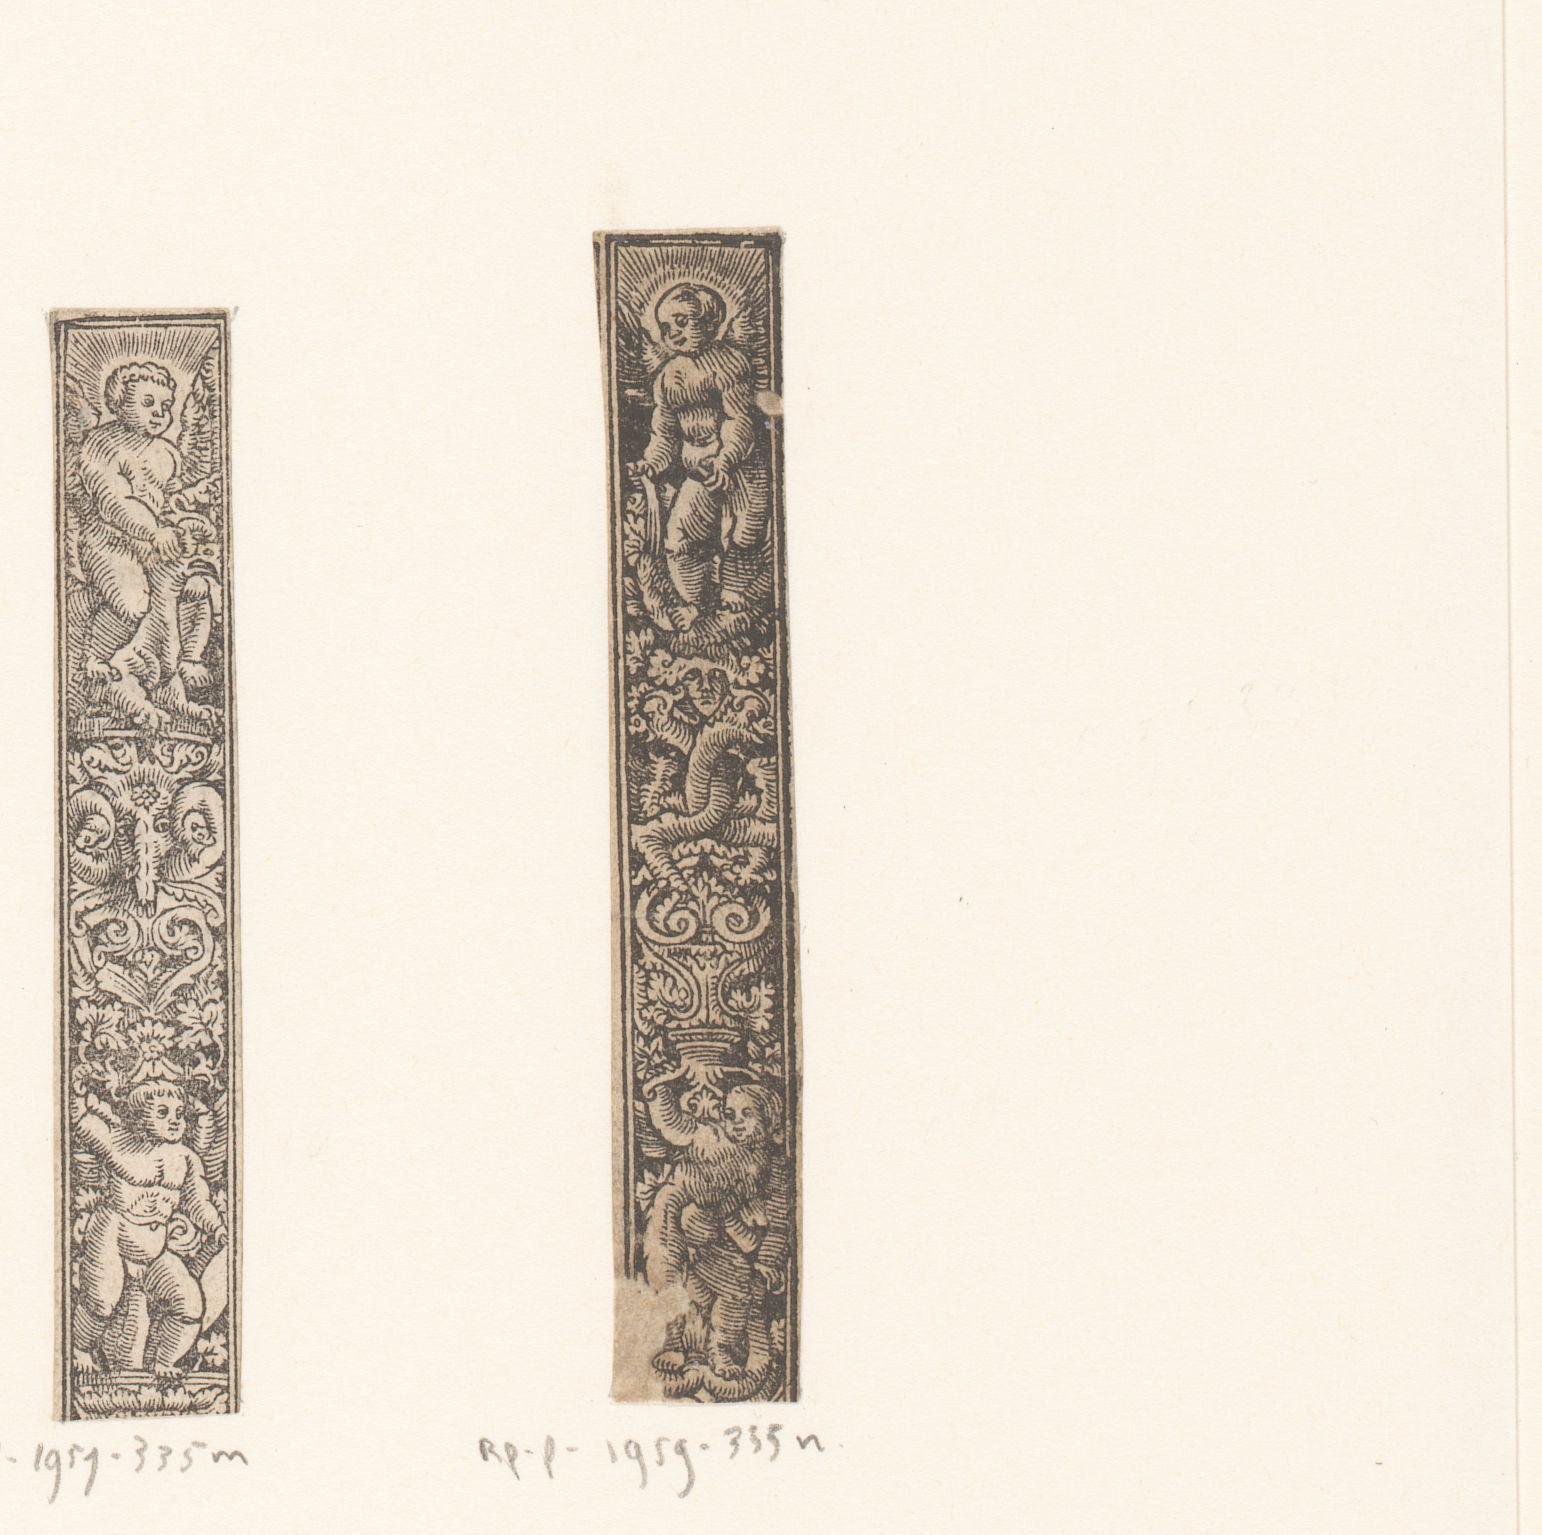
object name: book illustration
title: Verticaal fries met twee putti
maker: Anonymous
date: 1500-1599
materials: paper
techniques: woodcut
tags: anthropomorphic ornament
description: Prent afkomstig uit een onbekende publicatie.